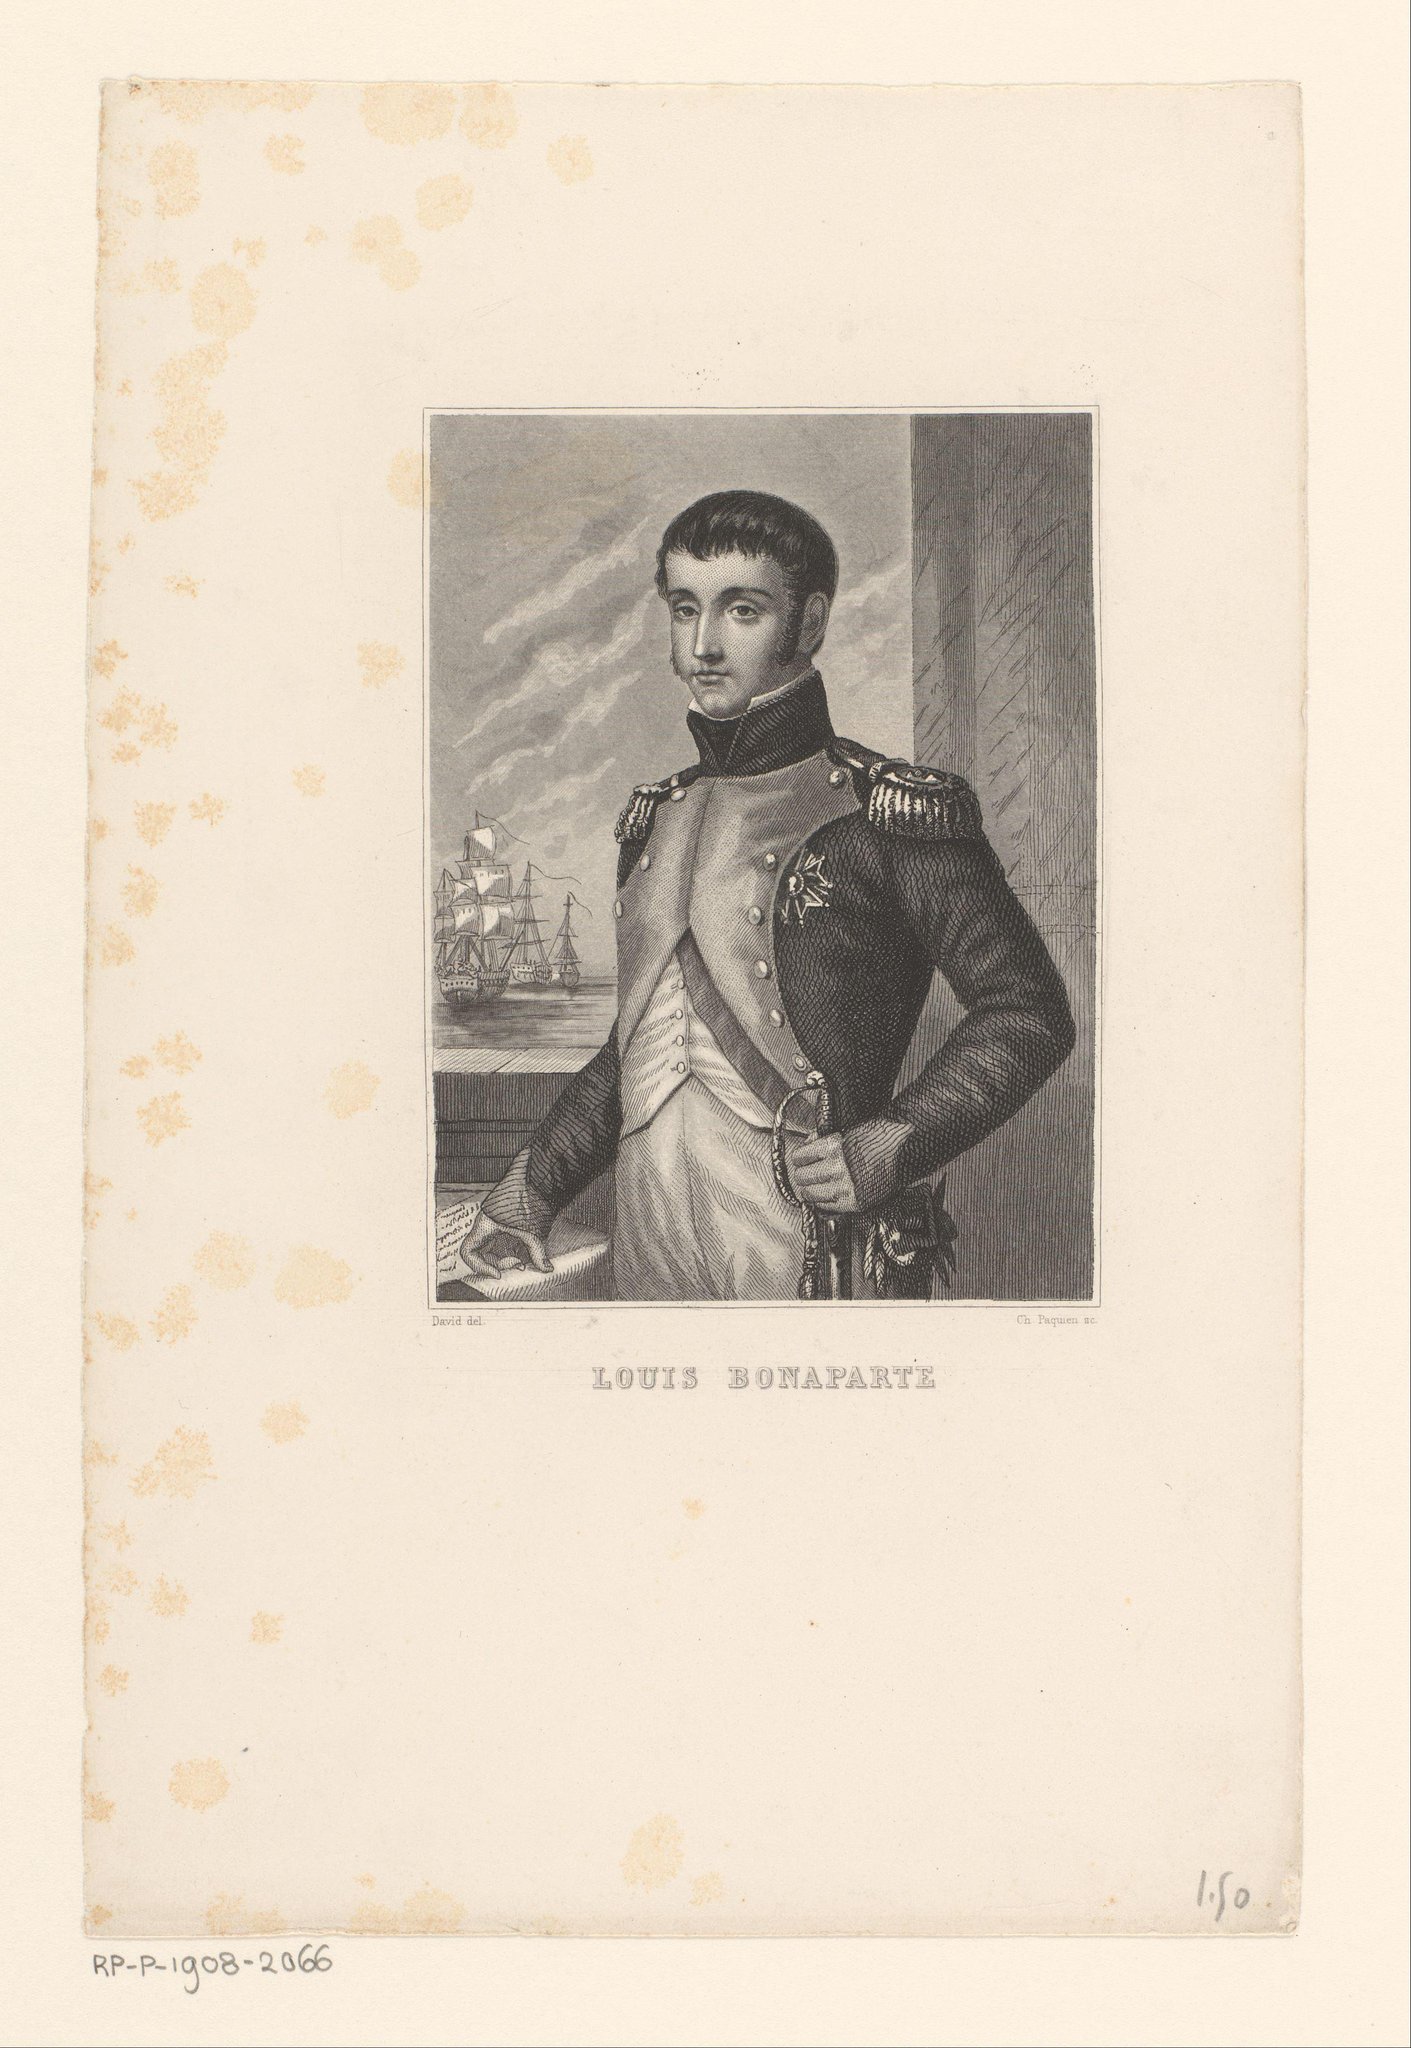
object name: print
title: Louis Bonaparte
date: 1800-1900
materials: paper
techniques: aquatint, etching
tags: louis napoleon (king of holland), historical persons, king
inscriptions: collector's mark: Lugt 2228